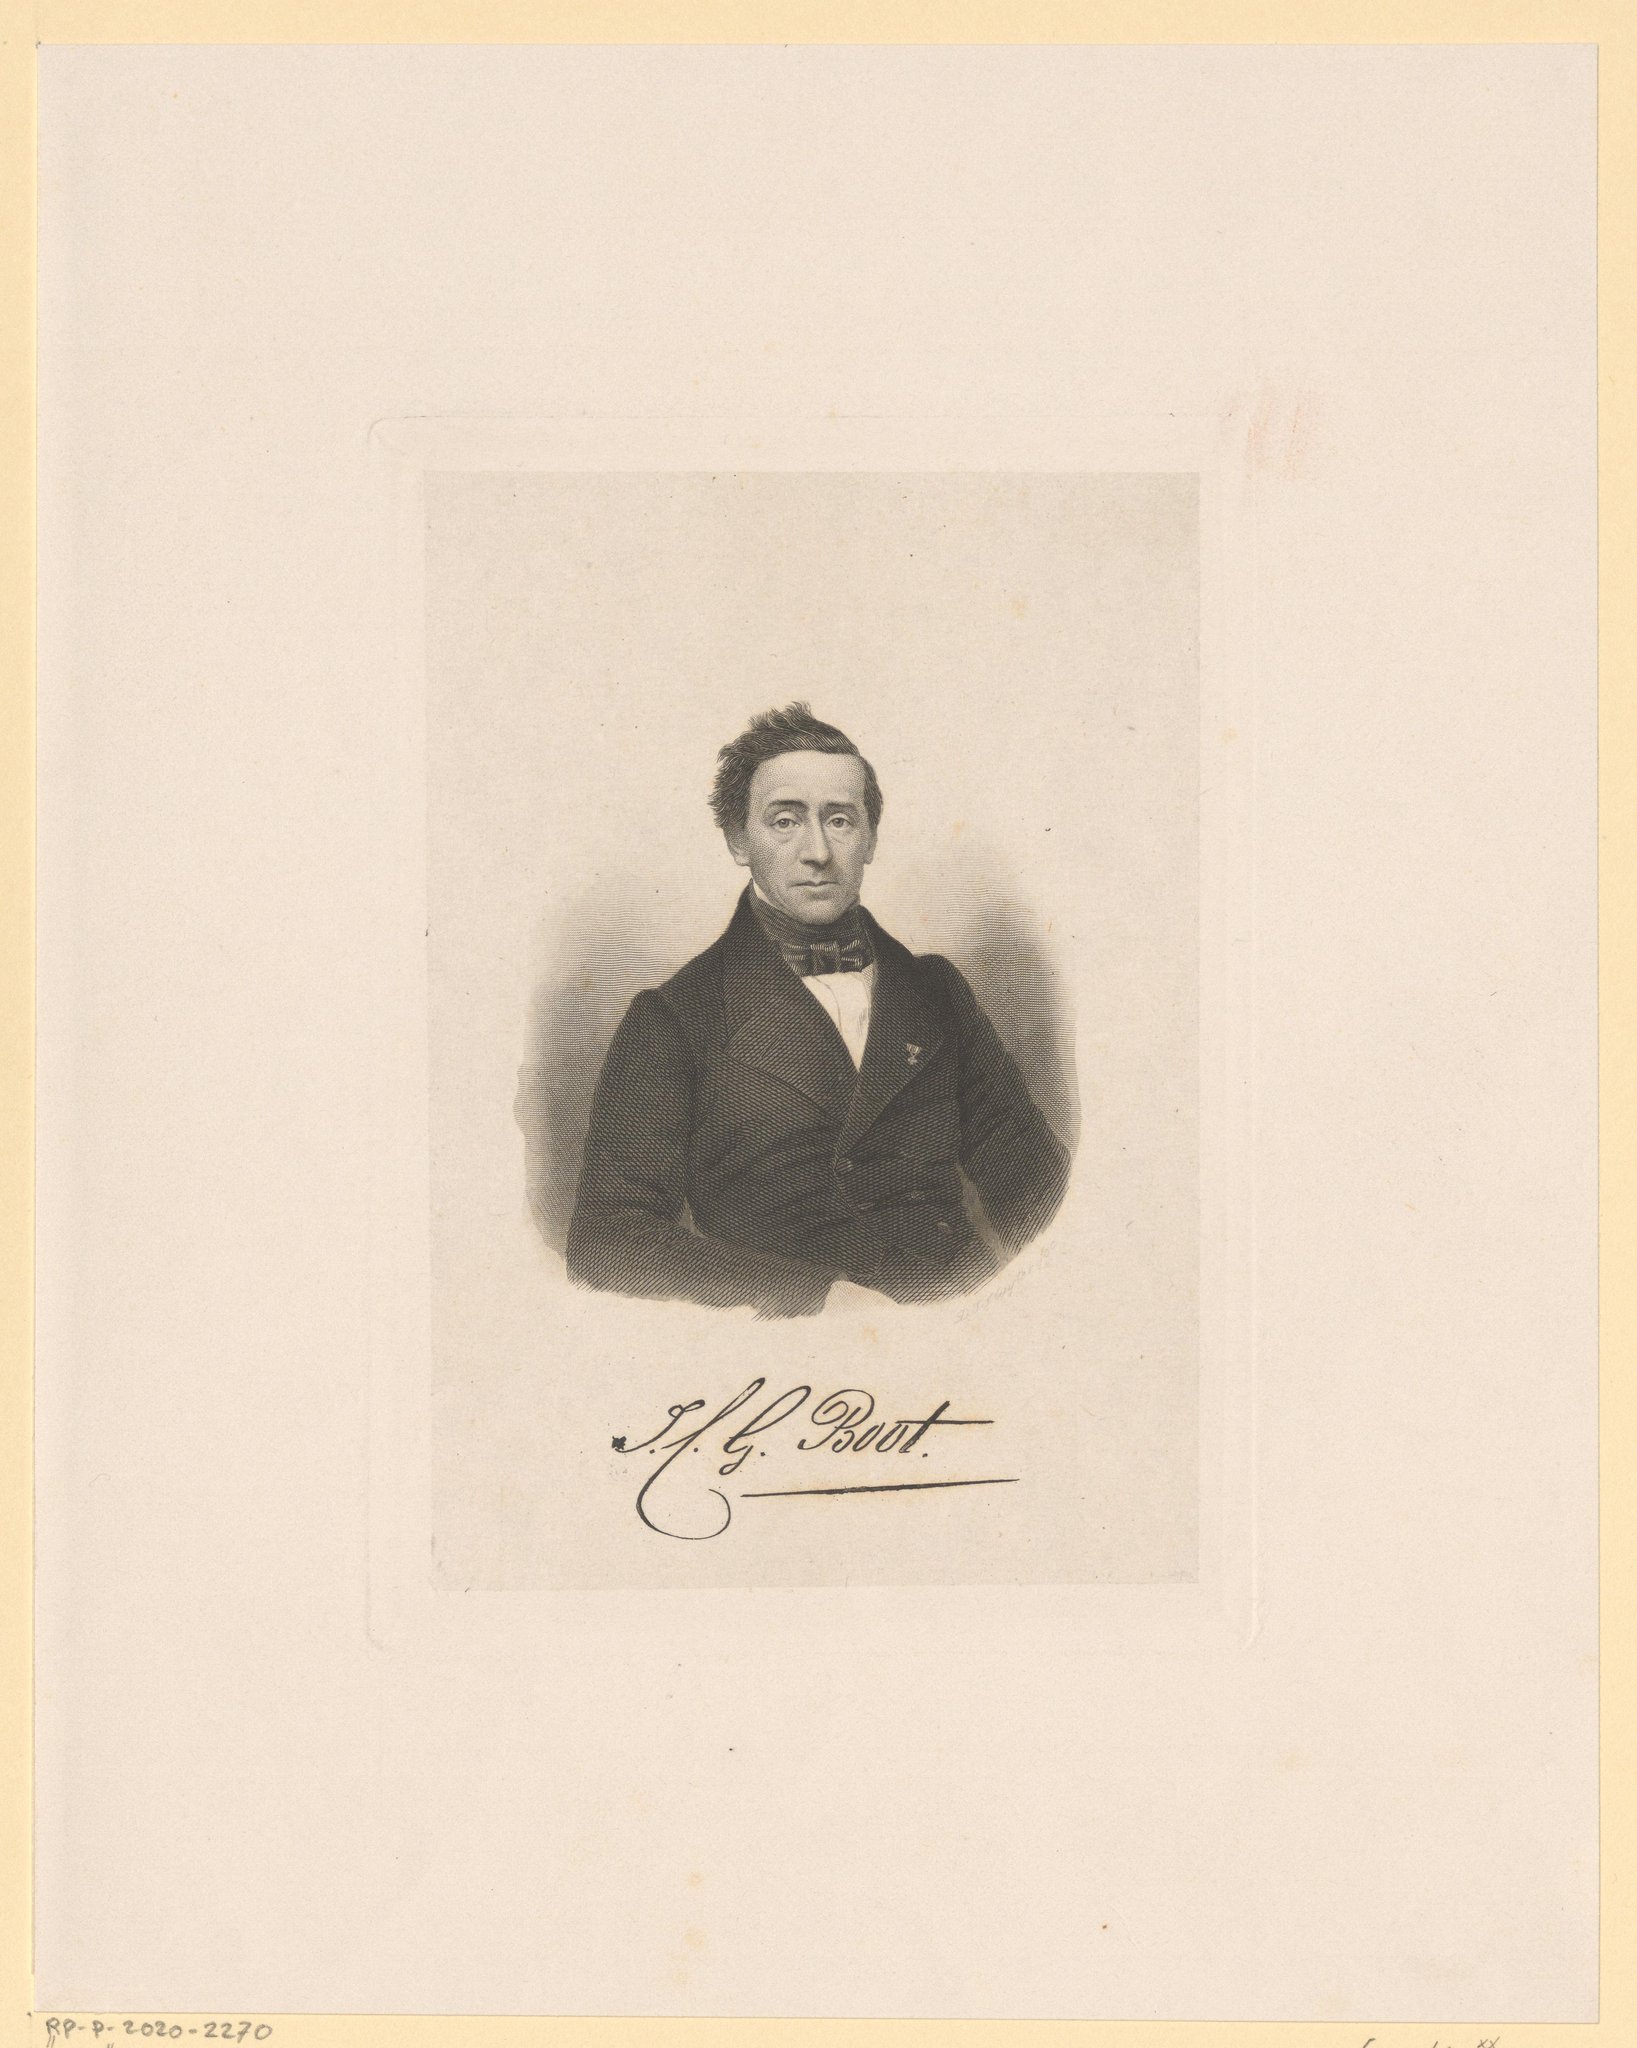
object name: print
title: Portret van Johan Cornelis Gerard Boot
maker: dirk jurriaan sluyter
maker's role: draughtsman, print maker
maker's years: 1811-1886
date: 1850-1886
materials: paper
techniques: engraving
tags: arnhem, amsterdam, scholar, philosopher, historical persons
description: Prent mogelijk uit: Amsterdamsch studenten-almanak. Amsterdam: s.n., 1860.